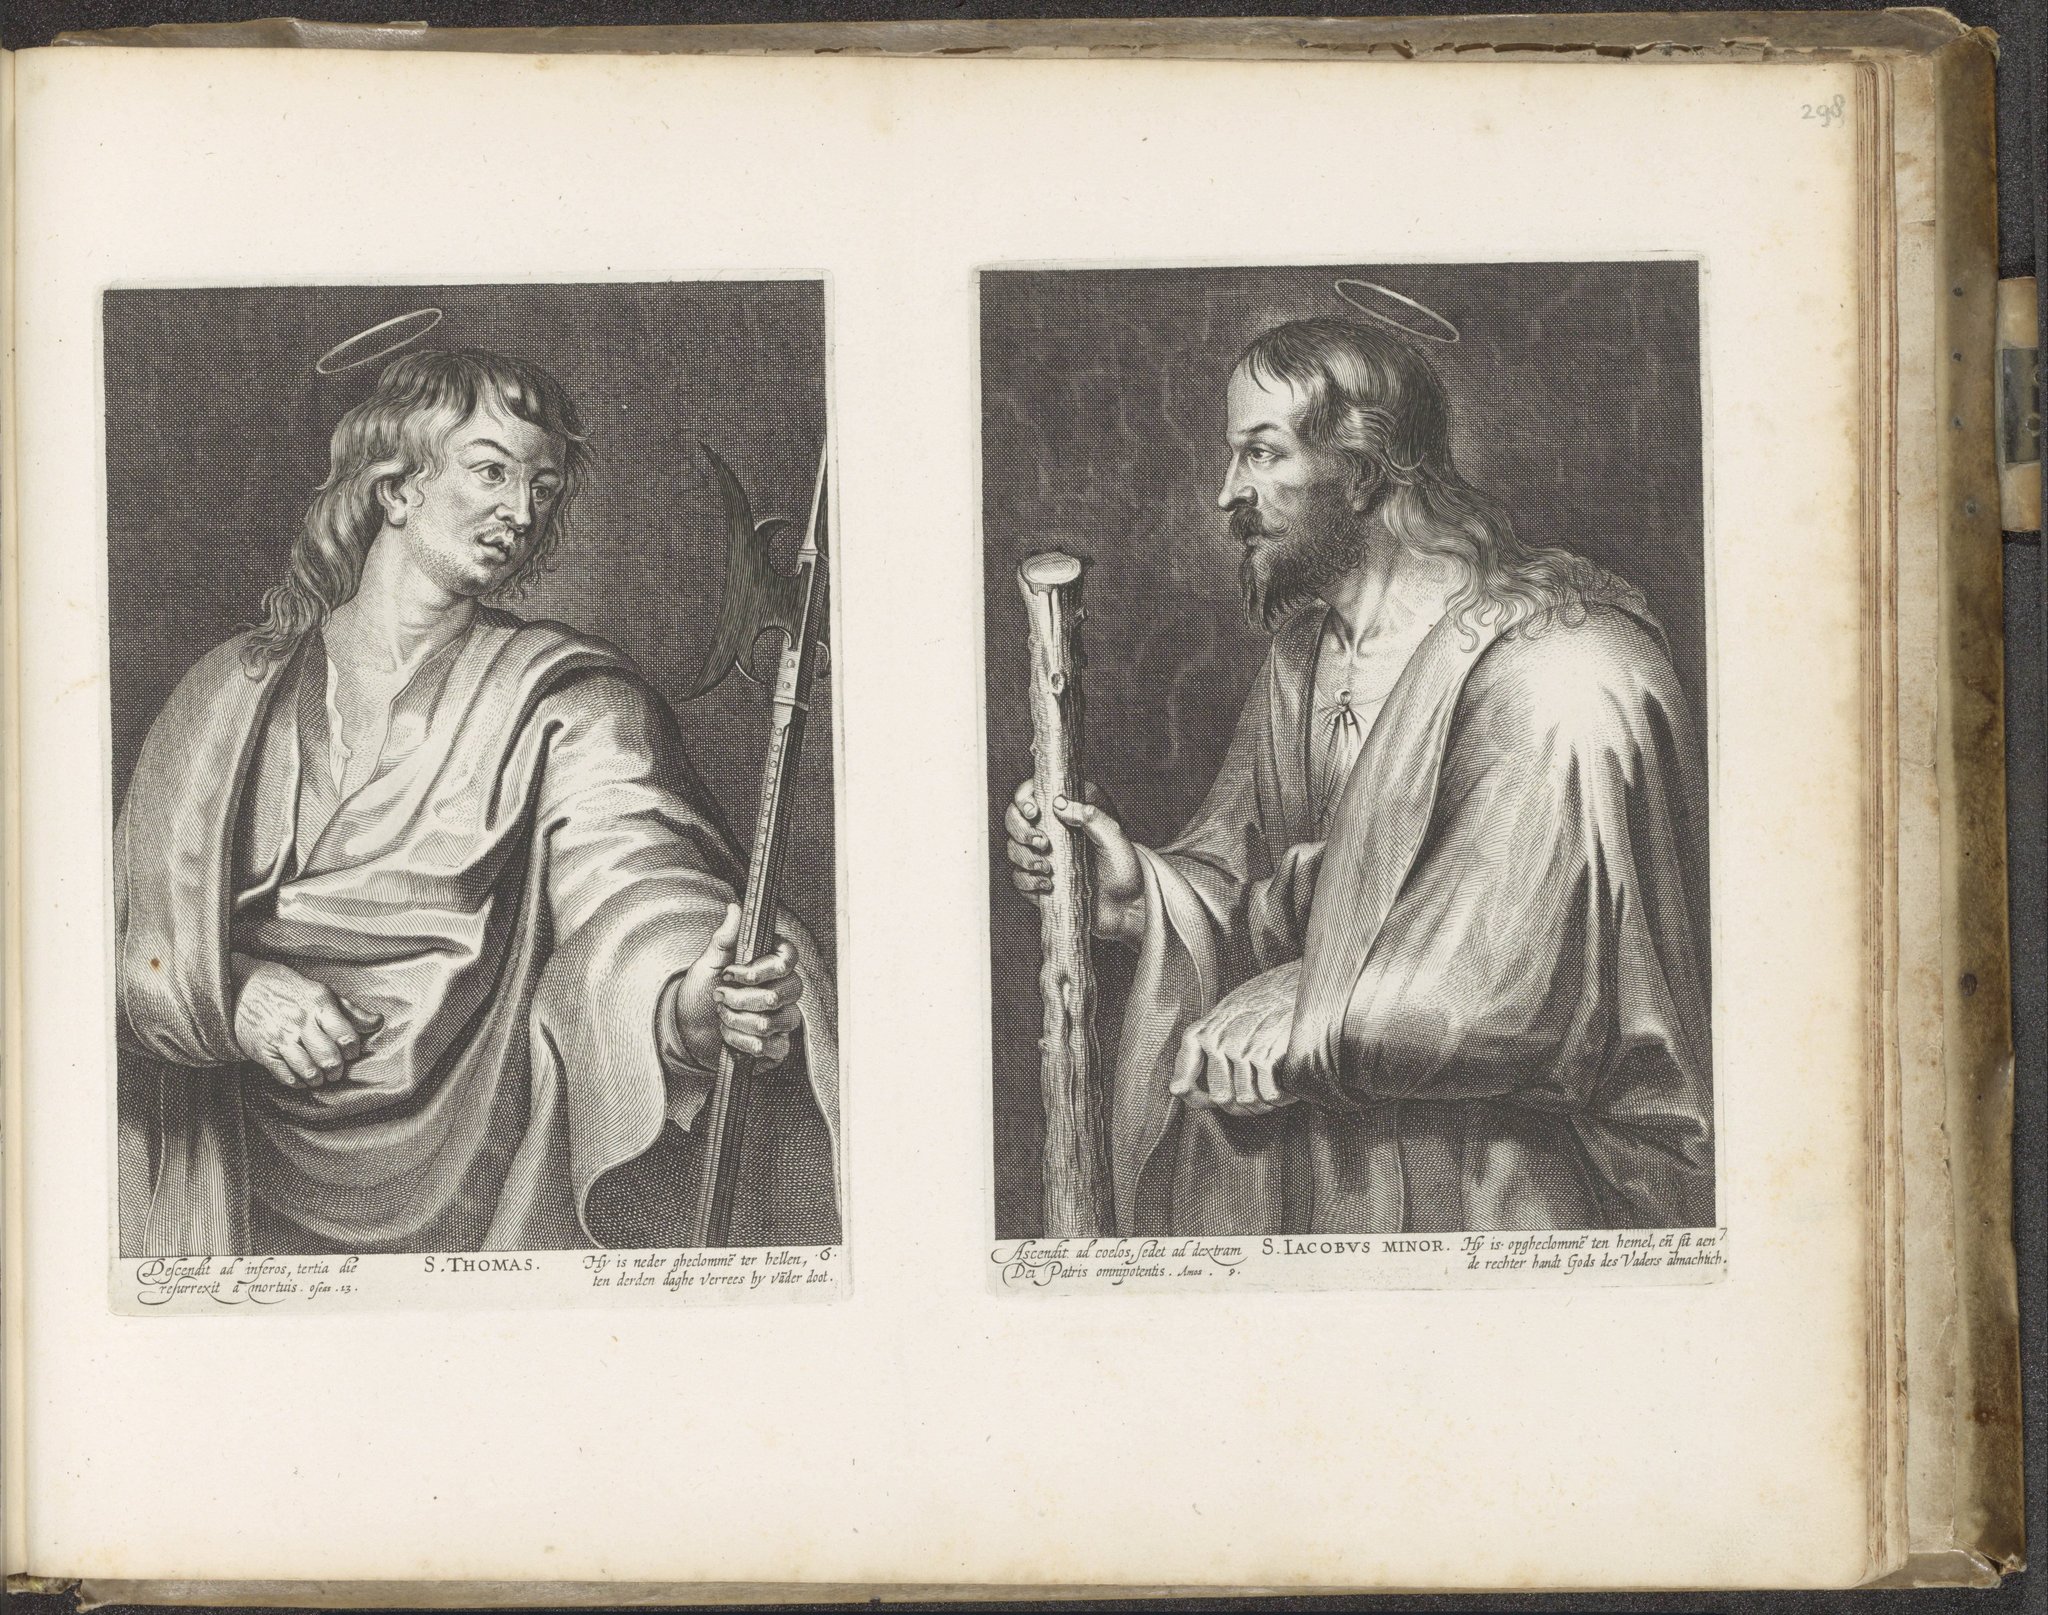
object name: album leaf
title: Apostel Tomas / Apostel Jakobus de Mindere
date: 1616-1626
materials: paper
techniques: engraving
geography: amsterdam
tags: the apostle thomas; possible attributes: book, chalice, girdle, heart, lance or spear, scroll, square, stones, the apostle james the less, first bishop of jerusalem; possible attributes: book, fuller's club, scroll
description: Twee voorstellingen op een albumblad. Links de apostel Tomas met hellebaard. Rechts Jakobus de Mindere met een knots. In beide ondermarges een tweeregelige tekst in het Latijn en Nederlands. De prent maakt deel uit van een album.